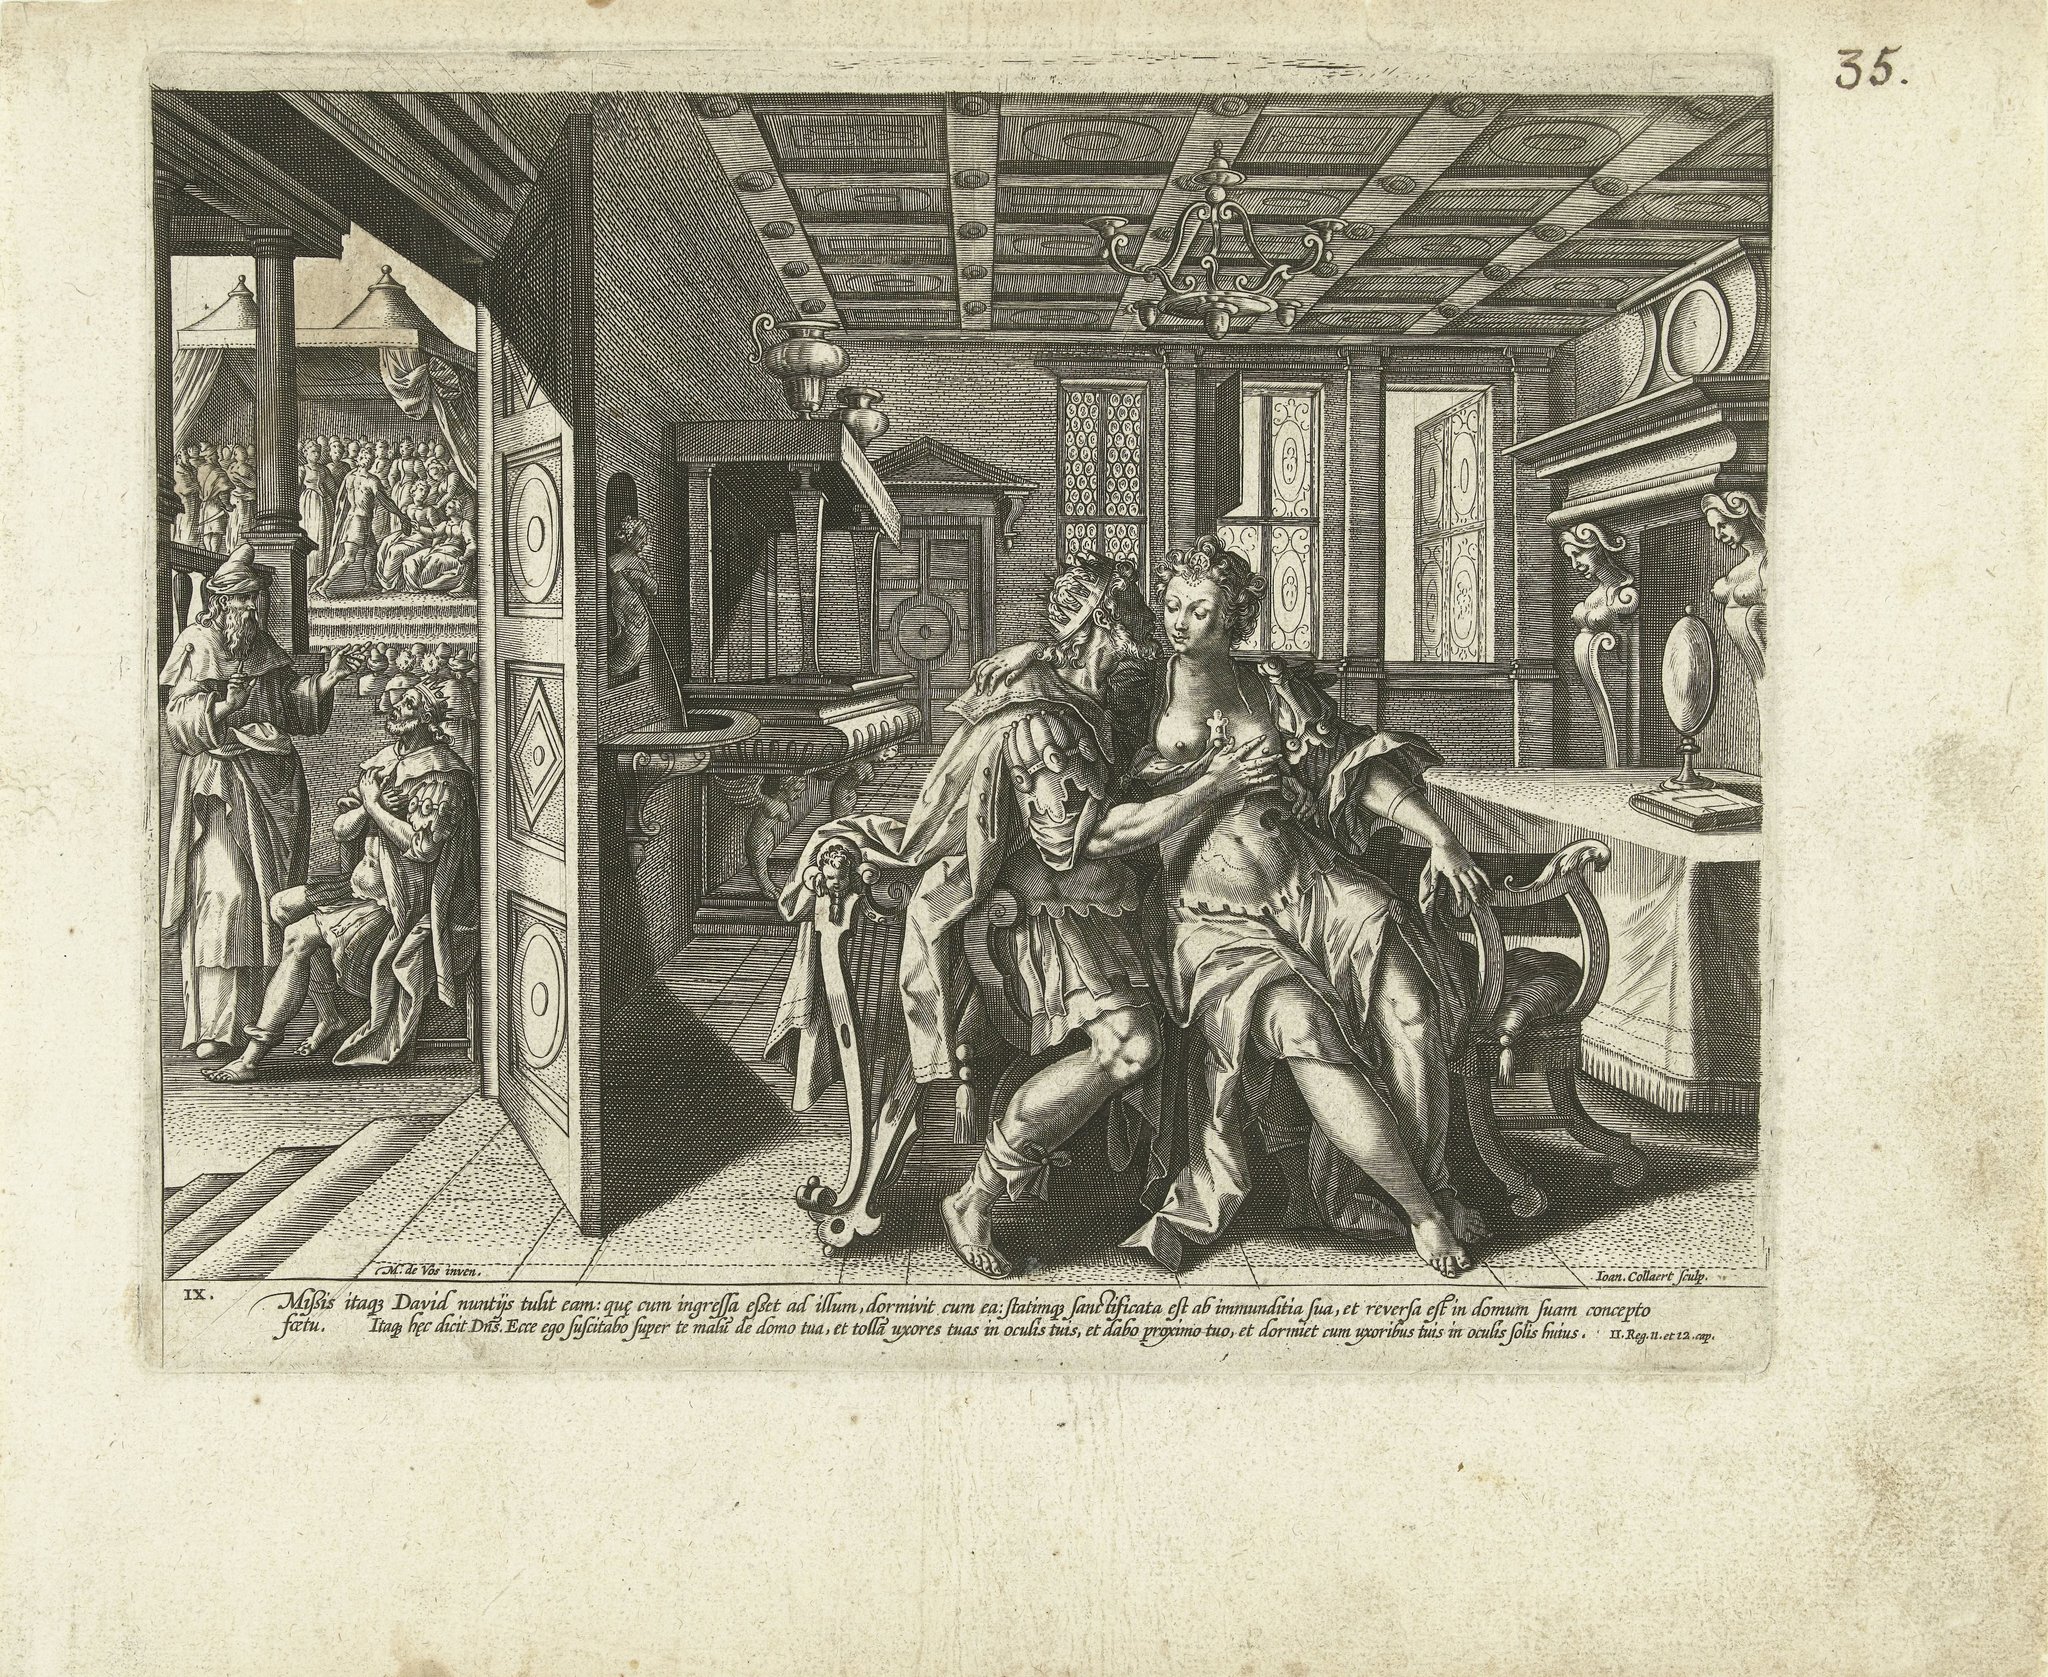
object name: print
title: David en Batseba: het negende Gebod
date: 1585-1589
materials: paper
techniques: engraving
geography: antwerp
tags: nathan accuses david of his misdeed, david and bathsheba as lovers, 'you shall not covet' ~ separate representation of the tenth of the ten commandments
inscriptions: number: ‘35’, collector's mark: Lugt 2228, collector's mark: Lugt 2760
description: Koning David heeft een relatie met Batseba, de vrouw van Uria (2 Samuël 11:1-26). In de achtergrond vertelt de profeet Natan aan David dat hij door God zal gestraft worden omdat hij in schending is van het negende Gebod: "Gij zult de vrouw van uw medemens niet begeren". De prent heeft een Latijns onderschrift. De prentserie beeldt de Tien Geboden uit door middel van scènes van het Oude Testament.